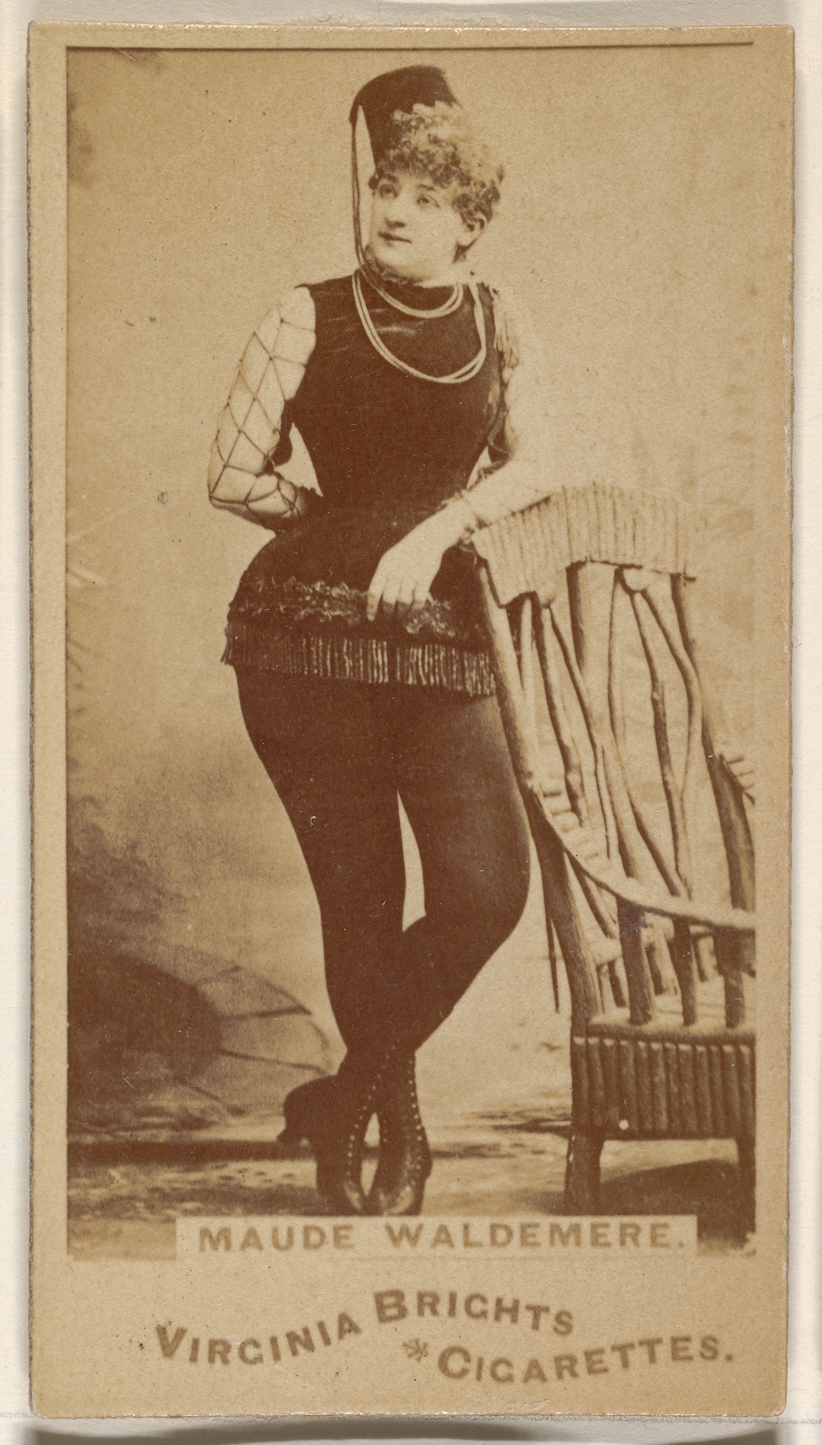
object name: photograph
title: Maude Waldemere, from the Actors and Actresses series (N45, Type 1) for Virginia Brights Cigarettes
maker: allen & ginter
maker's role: publisher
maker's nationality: american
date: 1888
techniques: albumen silver print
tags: portraits,women,actresses